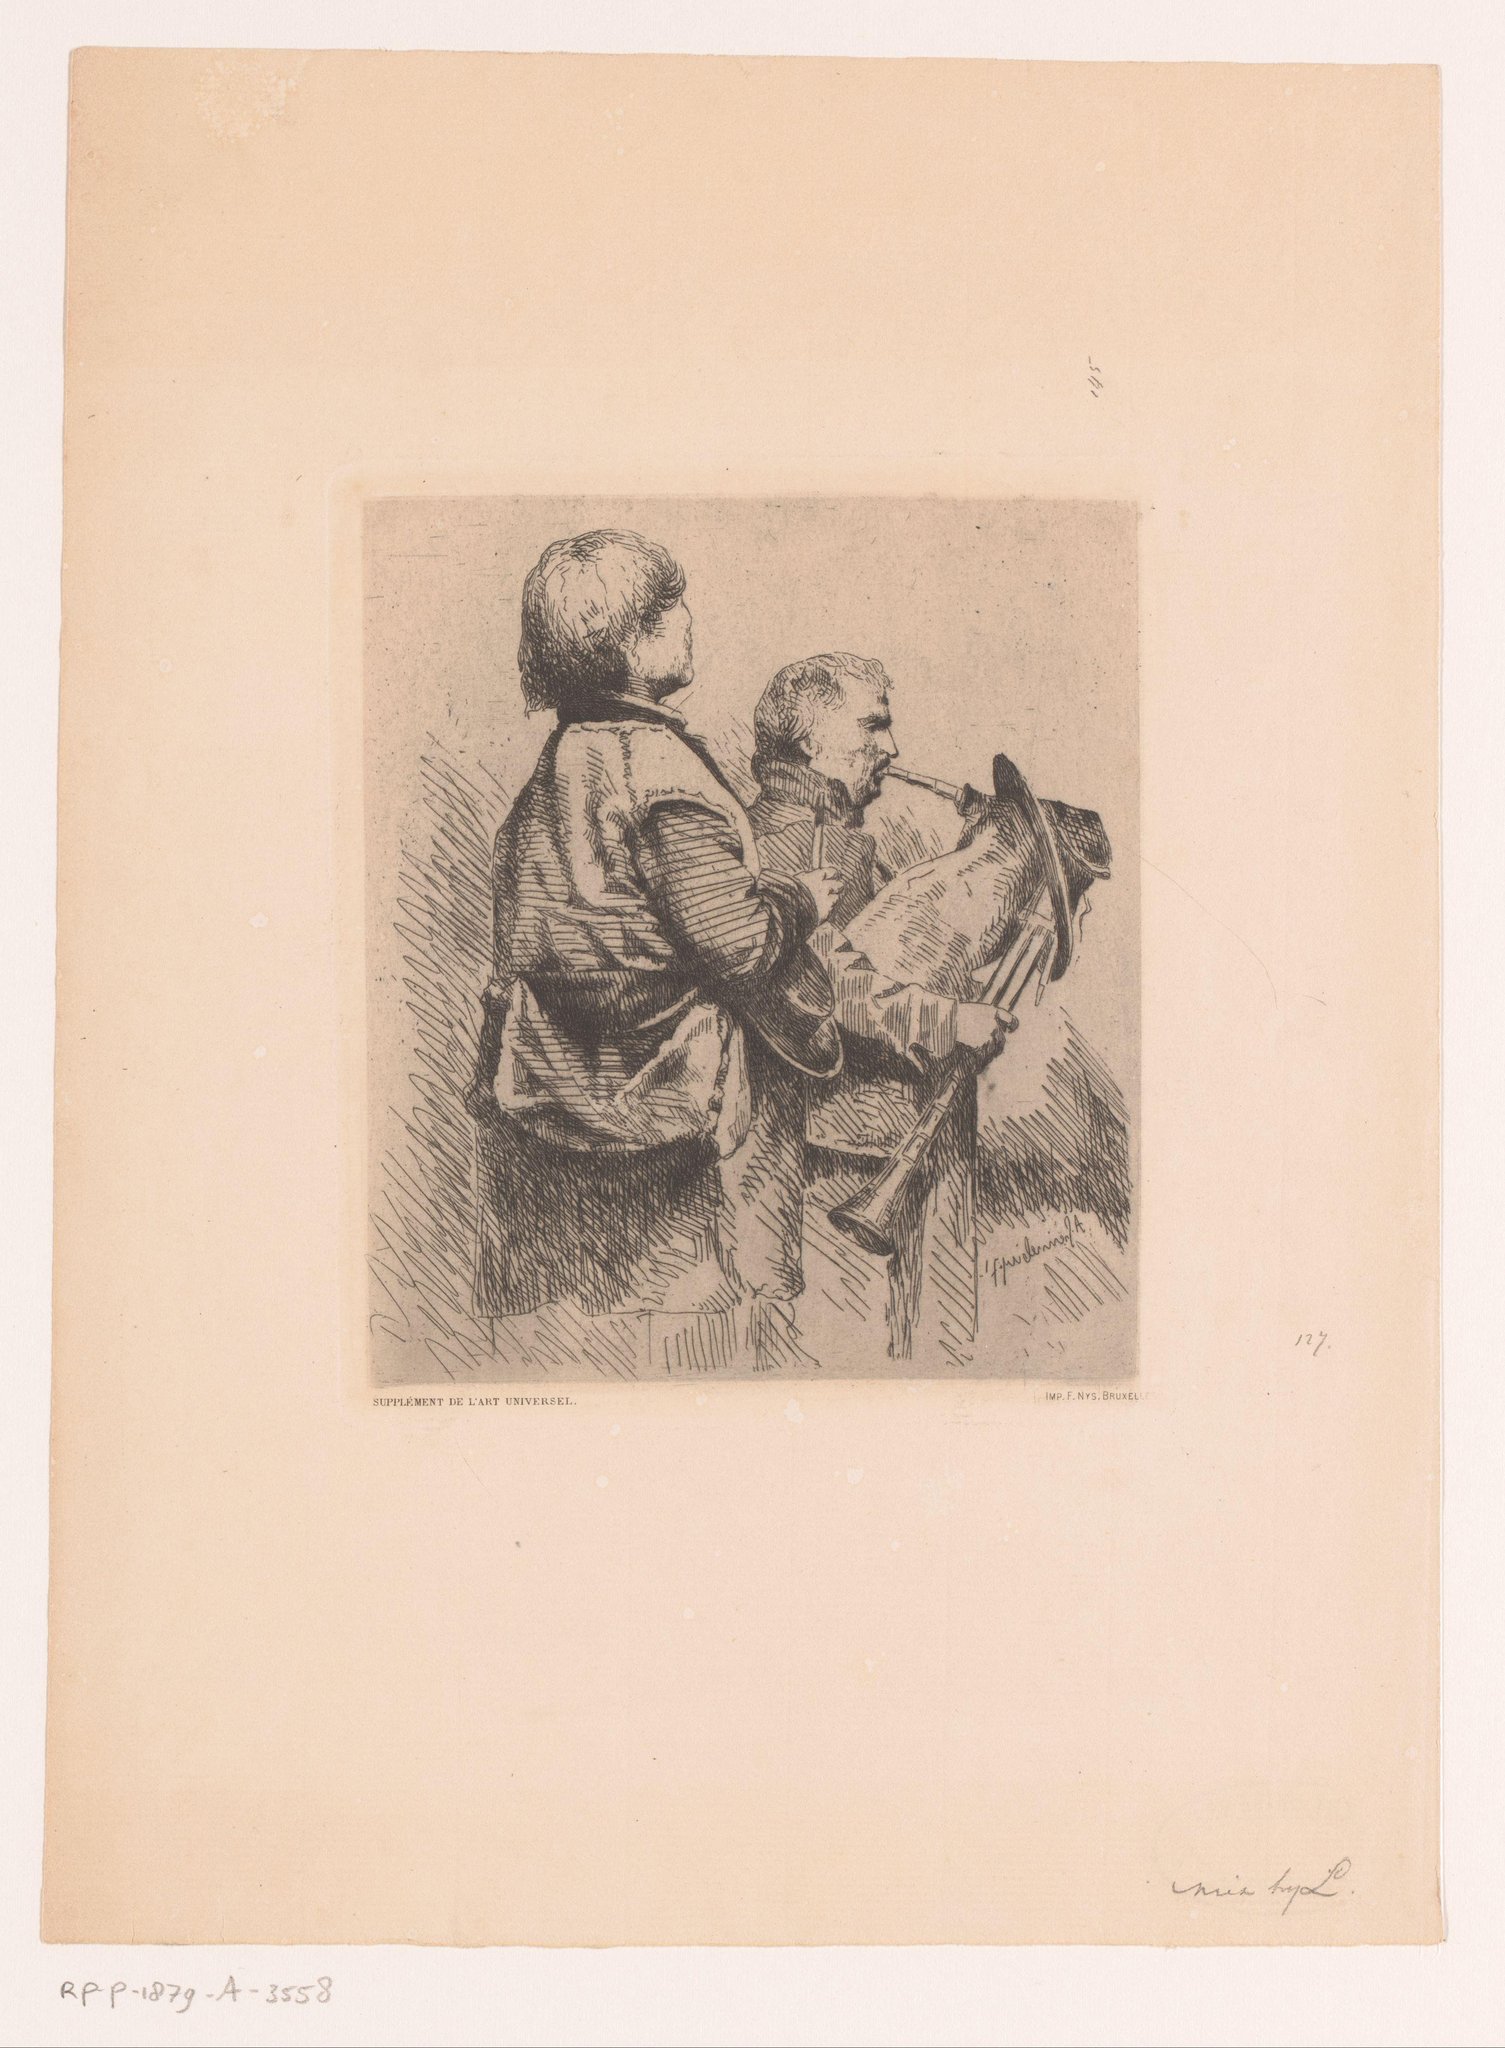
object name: print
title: Doedelzakspelers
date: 1871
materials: paper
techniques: etching, intaglio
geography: brussels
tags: one person playing wind instrument, bagpipe, musette, candle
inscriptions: collector's mark: Lugt 2228, collector's mark: Lugt 3073